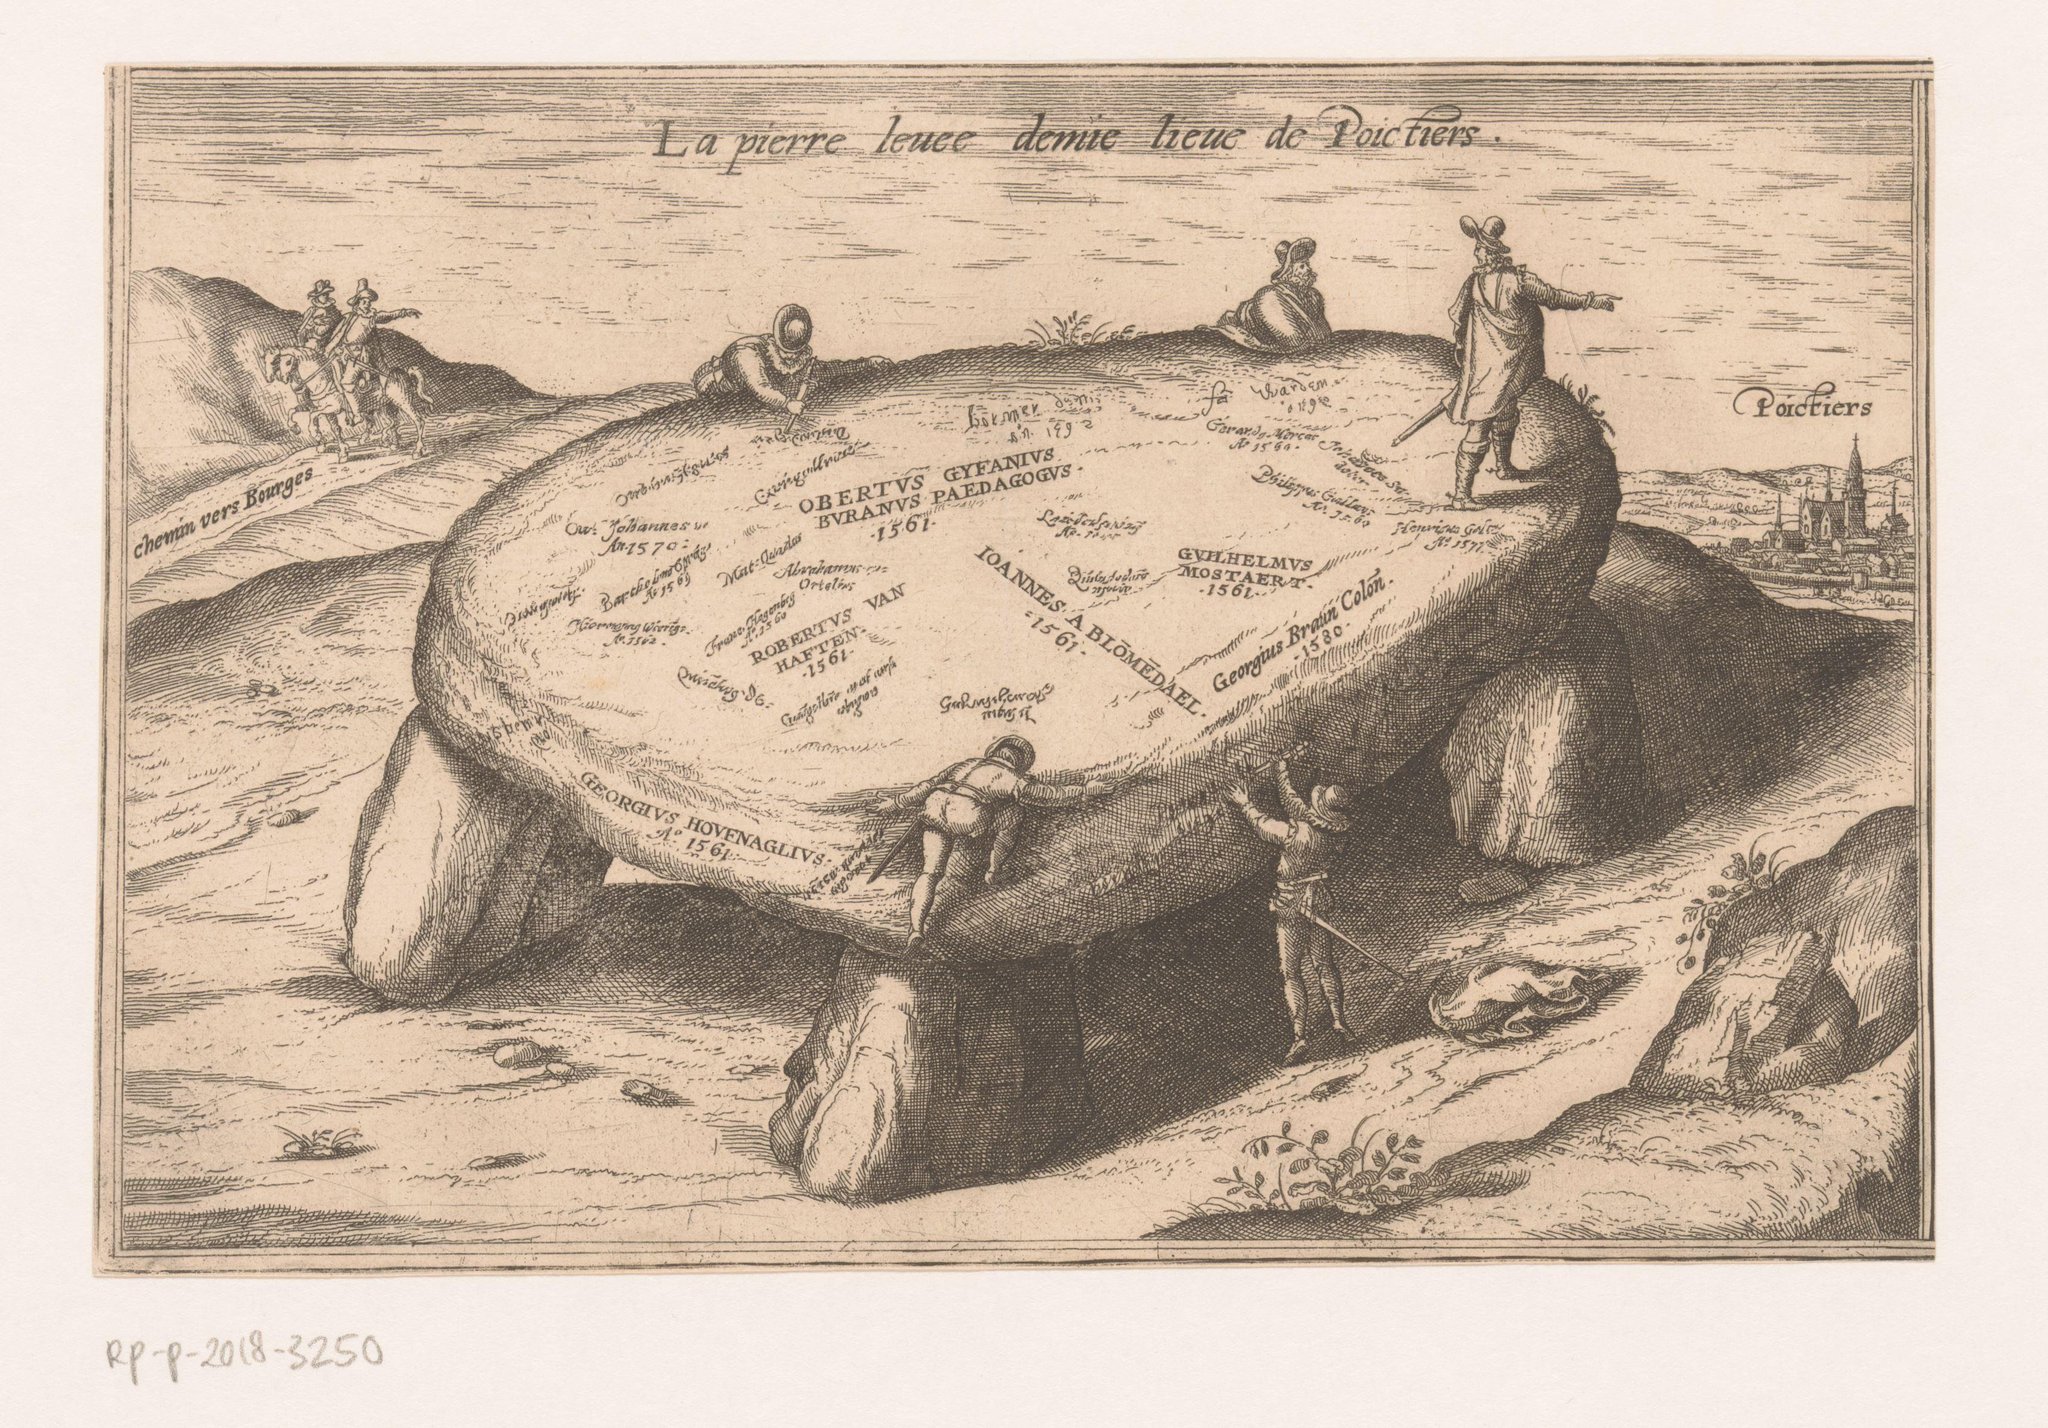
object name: print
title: La pierre levee demie lieue de Poictiers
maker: georg braun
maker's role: publisher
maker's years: 1541-1622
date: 1596-1598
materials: paper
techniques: etching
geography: cologne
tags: city-view, and landscape with man-made constructions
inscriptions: collector's mark: Lugt 2228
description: Prent is afgesneden van een blad met drie gezichten op Poitiers. Prent uit: Braun, Georg. Urbium Praeipuarum Mundi Theatrum Quintum Auctore Georgio Braunio Agrippinate. Keulen, 1596-1598.